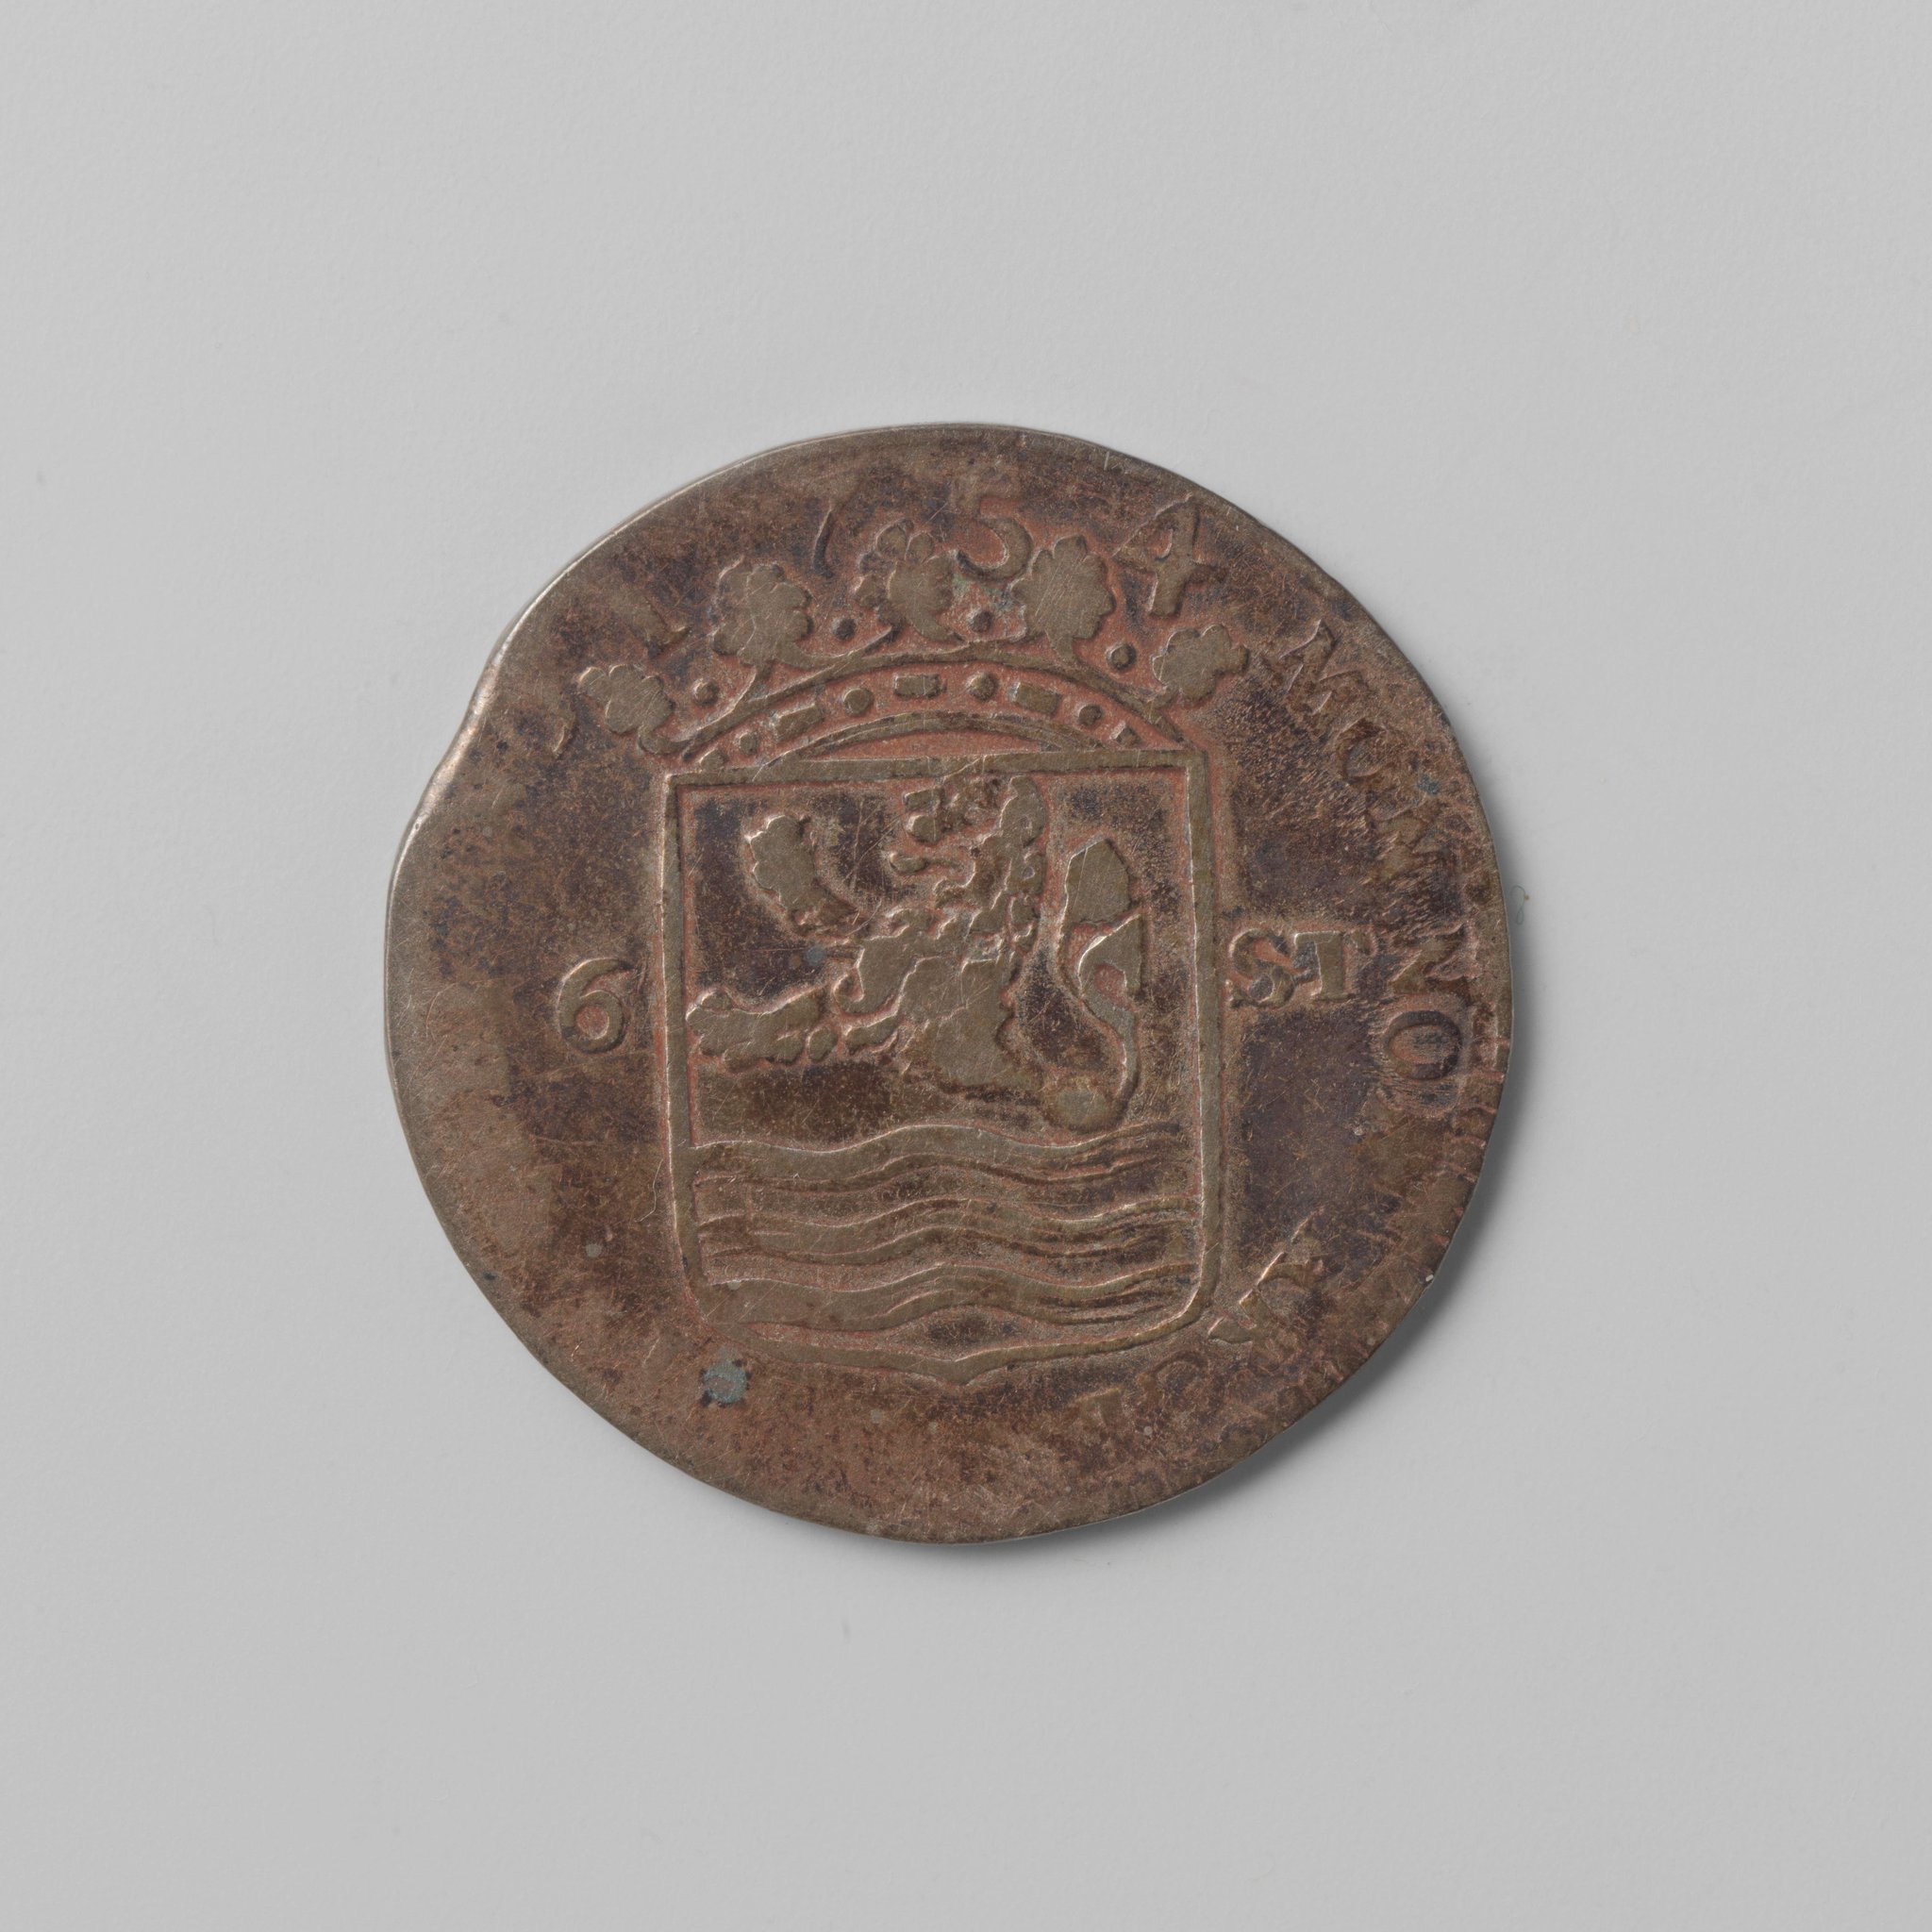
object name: coin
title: Zeeuwse scheepjesschelling, 1754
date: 1754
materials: silver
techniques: striking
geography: middelburg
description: Zilveren munt. Voorzijde: tussen waarde-aanduiding 6 ST gekroond wapenschild van Zeeland. Boven kroon jaartal. Keerzijde: oorlogsschip met zeilen naar rechts.